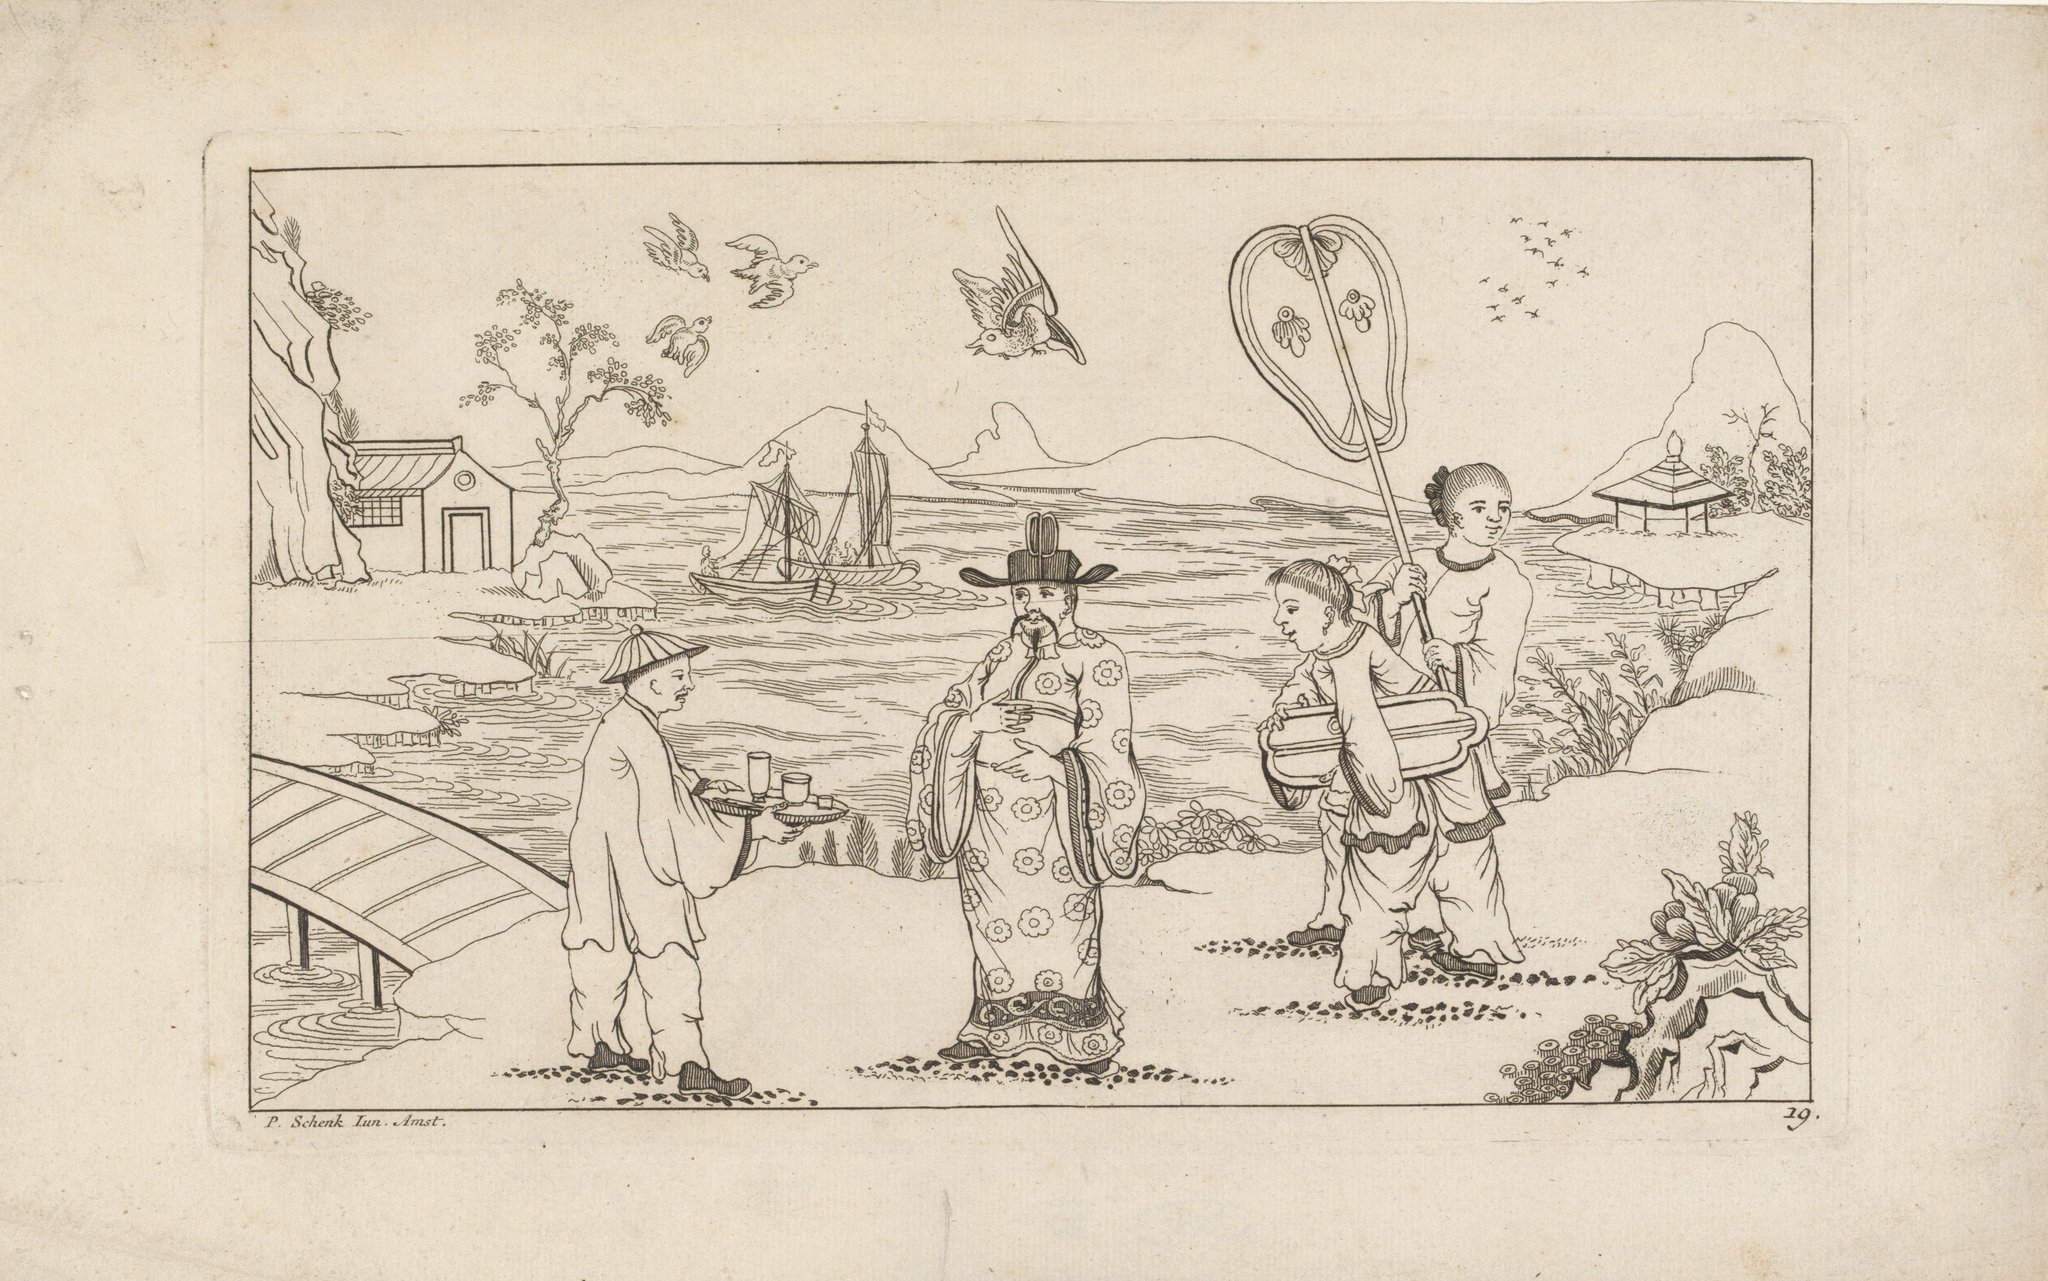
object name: print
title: Landscape with a Chinese Servant Bringing Tea to a Master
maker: pieter schenk (ii)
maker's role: draughtsman, print maker, publisher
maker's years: 1693-1775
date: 1715-1725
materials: paper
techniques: etching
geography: amsterdam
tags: tea-ceremony - cc - out of doors, chinese, water course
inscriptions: collector's mark: Lugt 2760, collector's mark: Lugt 2228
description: A servant carries over a tea tray to his master, wearing a floral-patterned robe, similar to the one worn by Peter August across the room. Schenk the younger’s interest in depicting China must have rubbed off from his father. Schenk I’s social circle included prominent Dutchmen, such as the Amsterdam mayor and collector of Chinese objects Nicolaes Witsen (1641-1717) and the professor of Oriental languages Adriaan Reland (1676-1718).